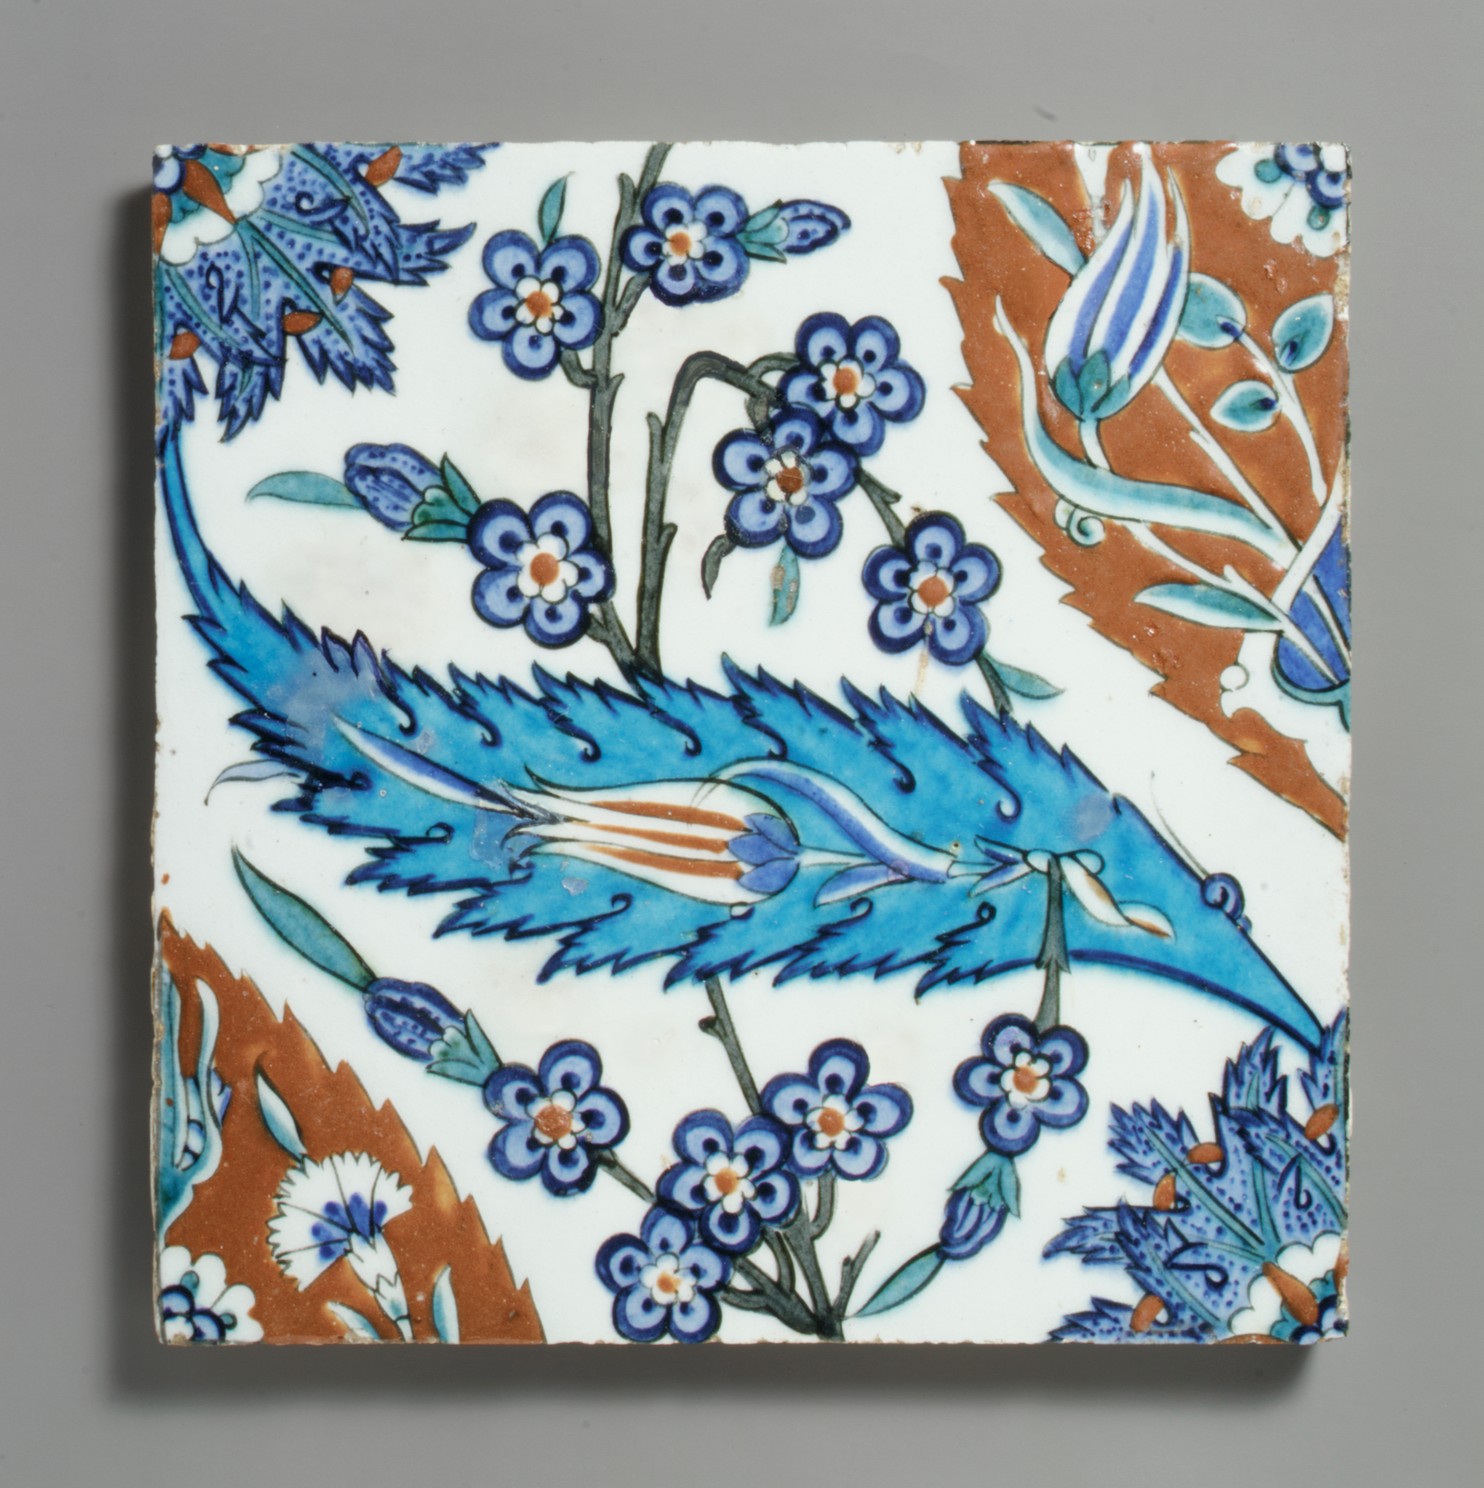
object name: square tile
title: Tile with Saz Leave, Tulips, and Hyacinth Flowers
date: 1551-1575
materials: glaze, stonepaste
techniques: painting, polychrome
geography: turkey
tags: tulips,leaves